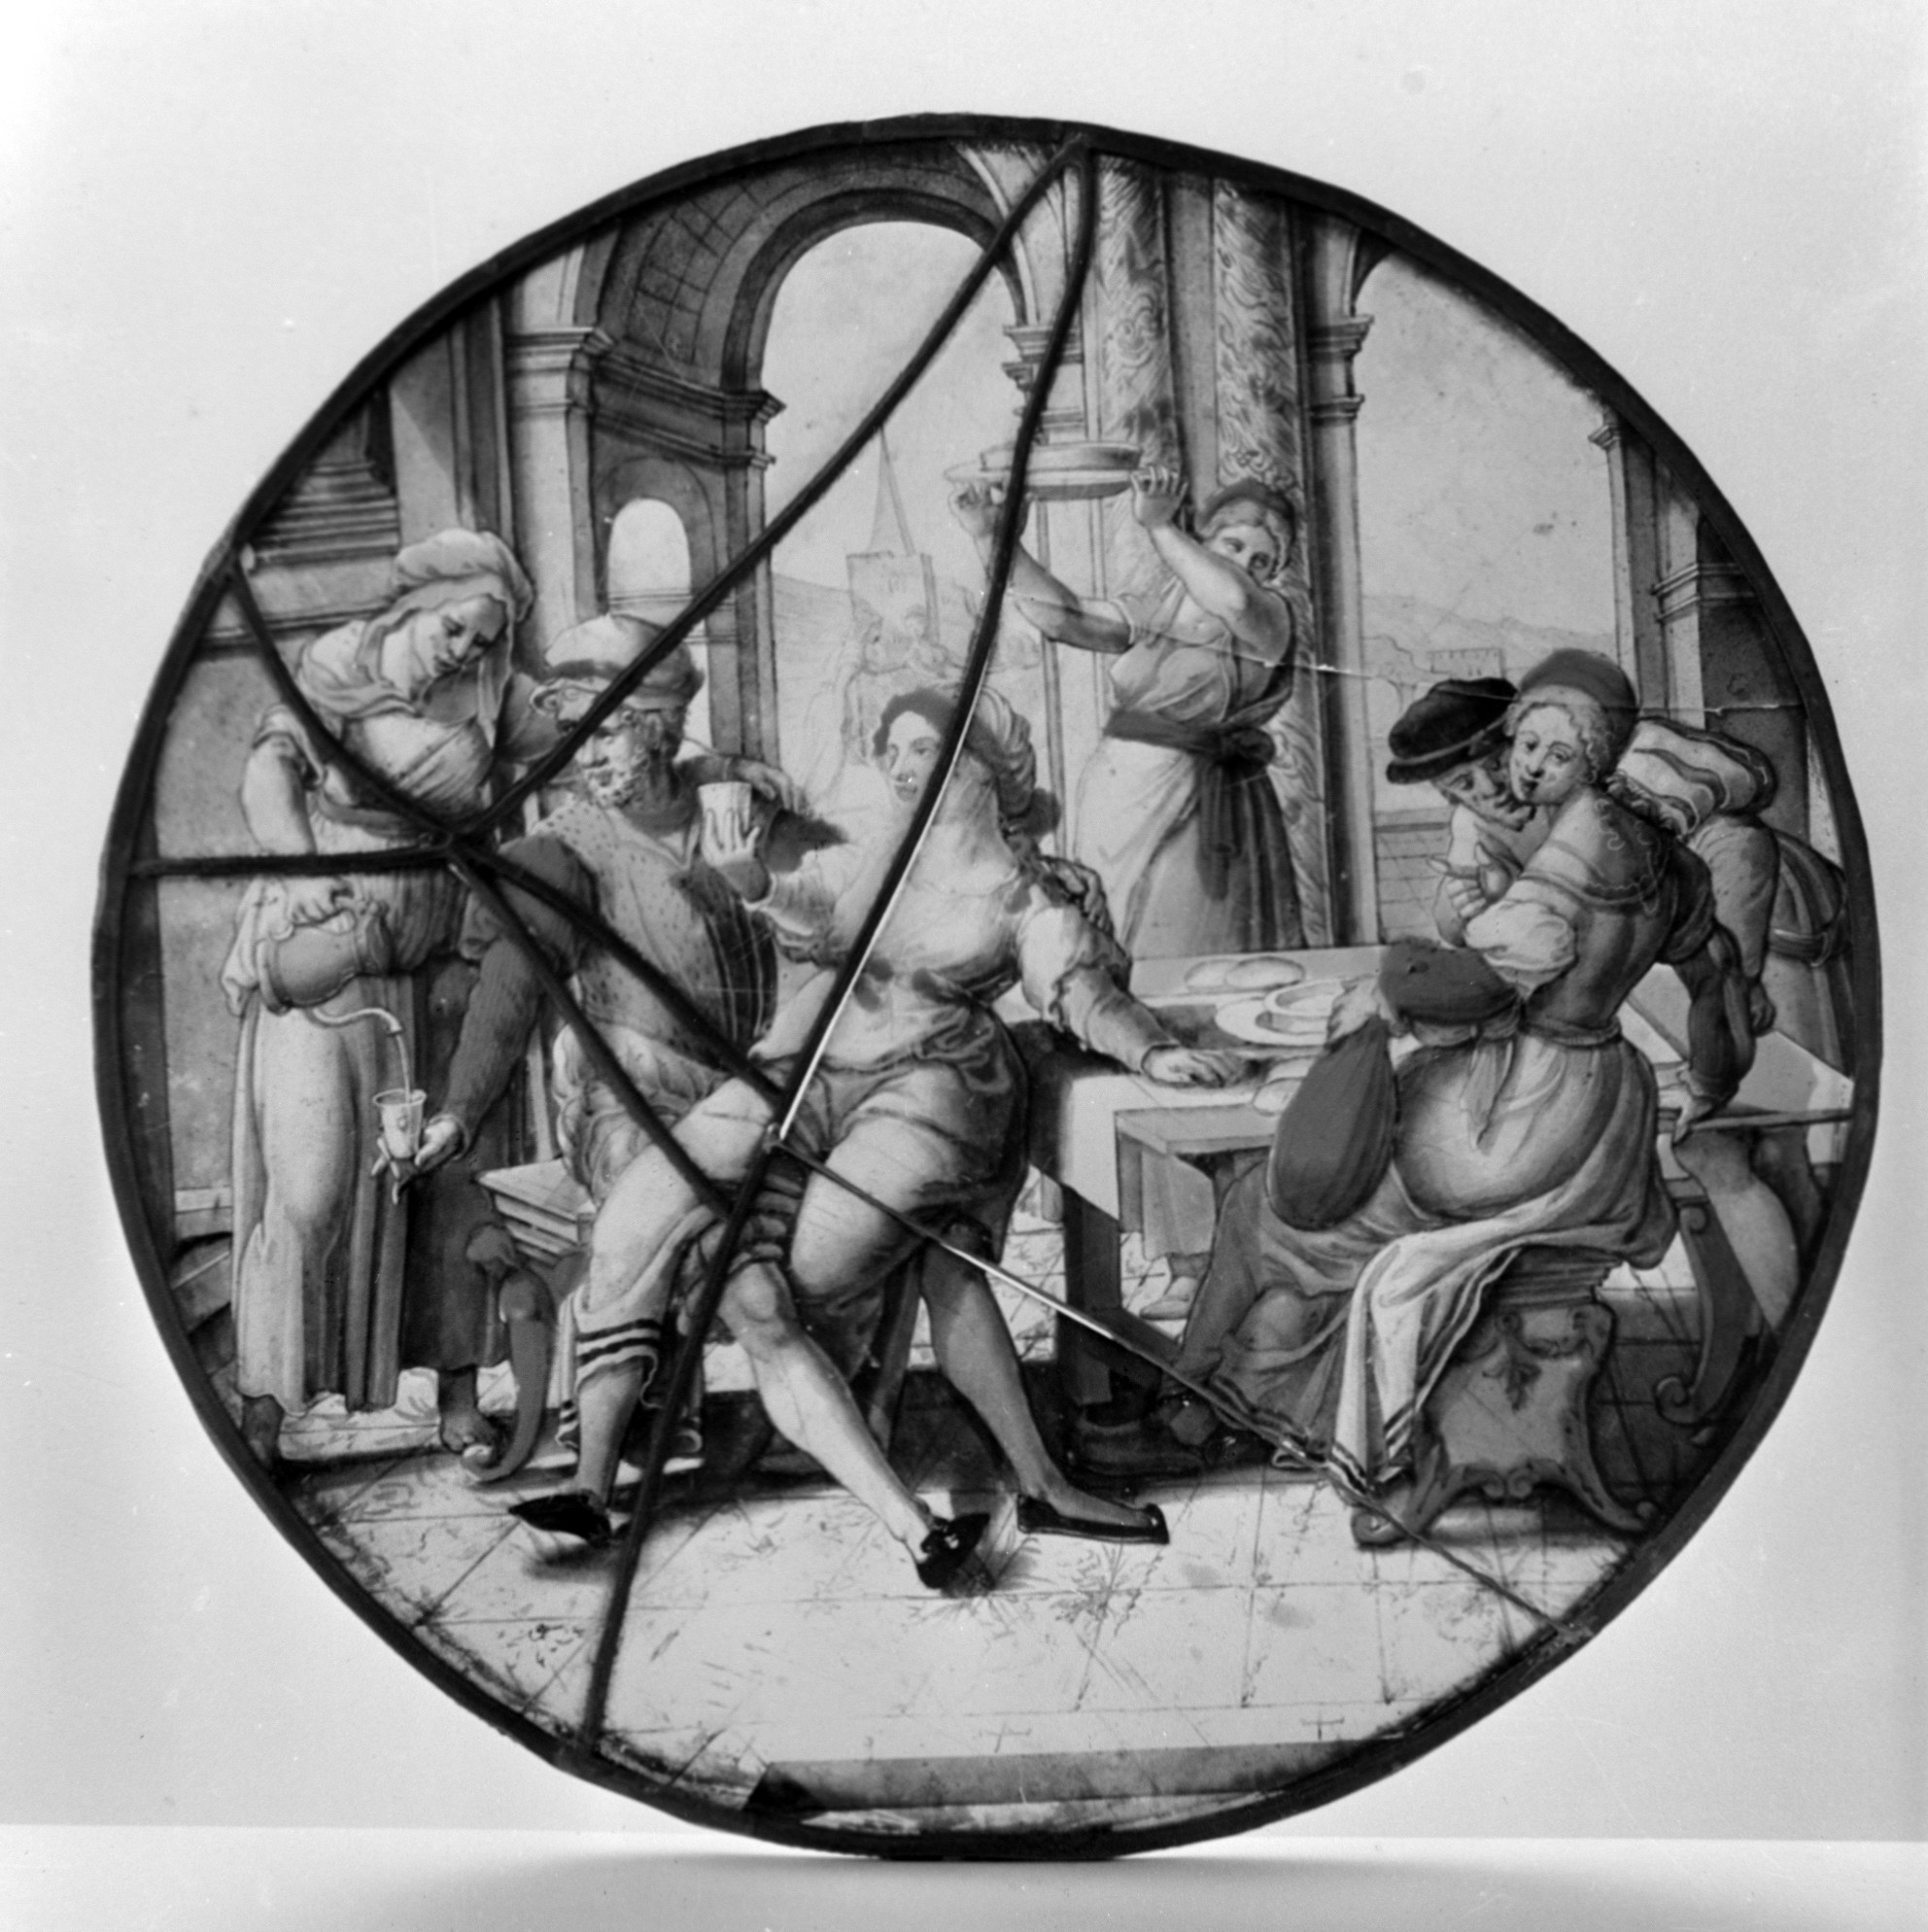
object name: roundel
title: The Prodigal Son Feasting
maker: pieter coecke van aelst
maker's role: designer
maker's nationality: netherlandish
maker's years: 1502-1550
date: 1540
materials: glass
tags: drunkenness,men,women,party,drinking